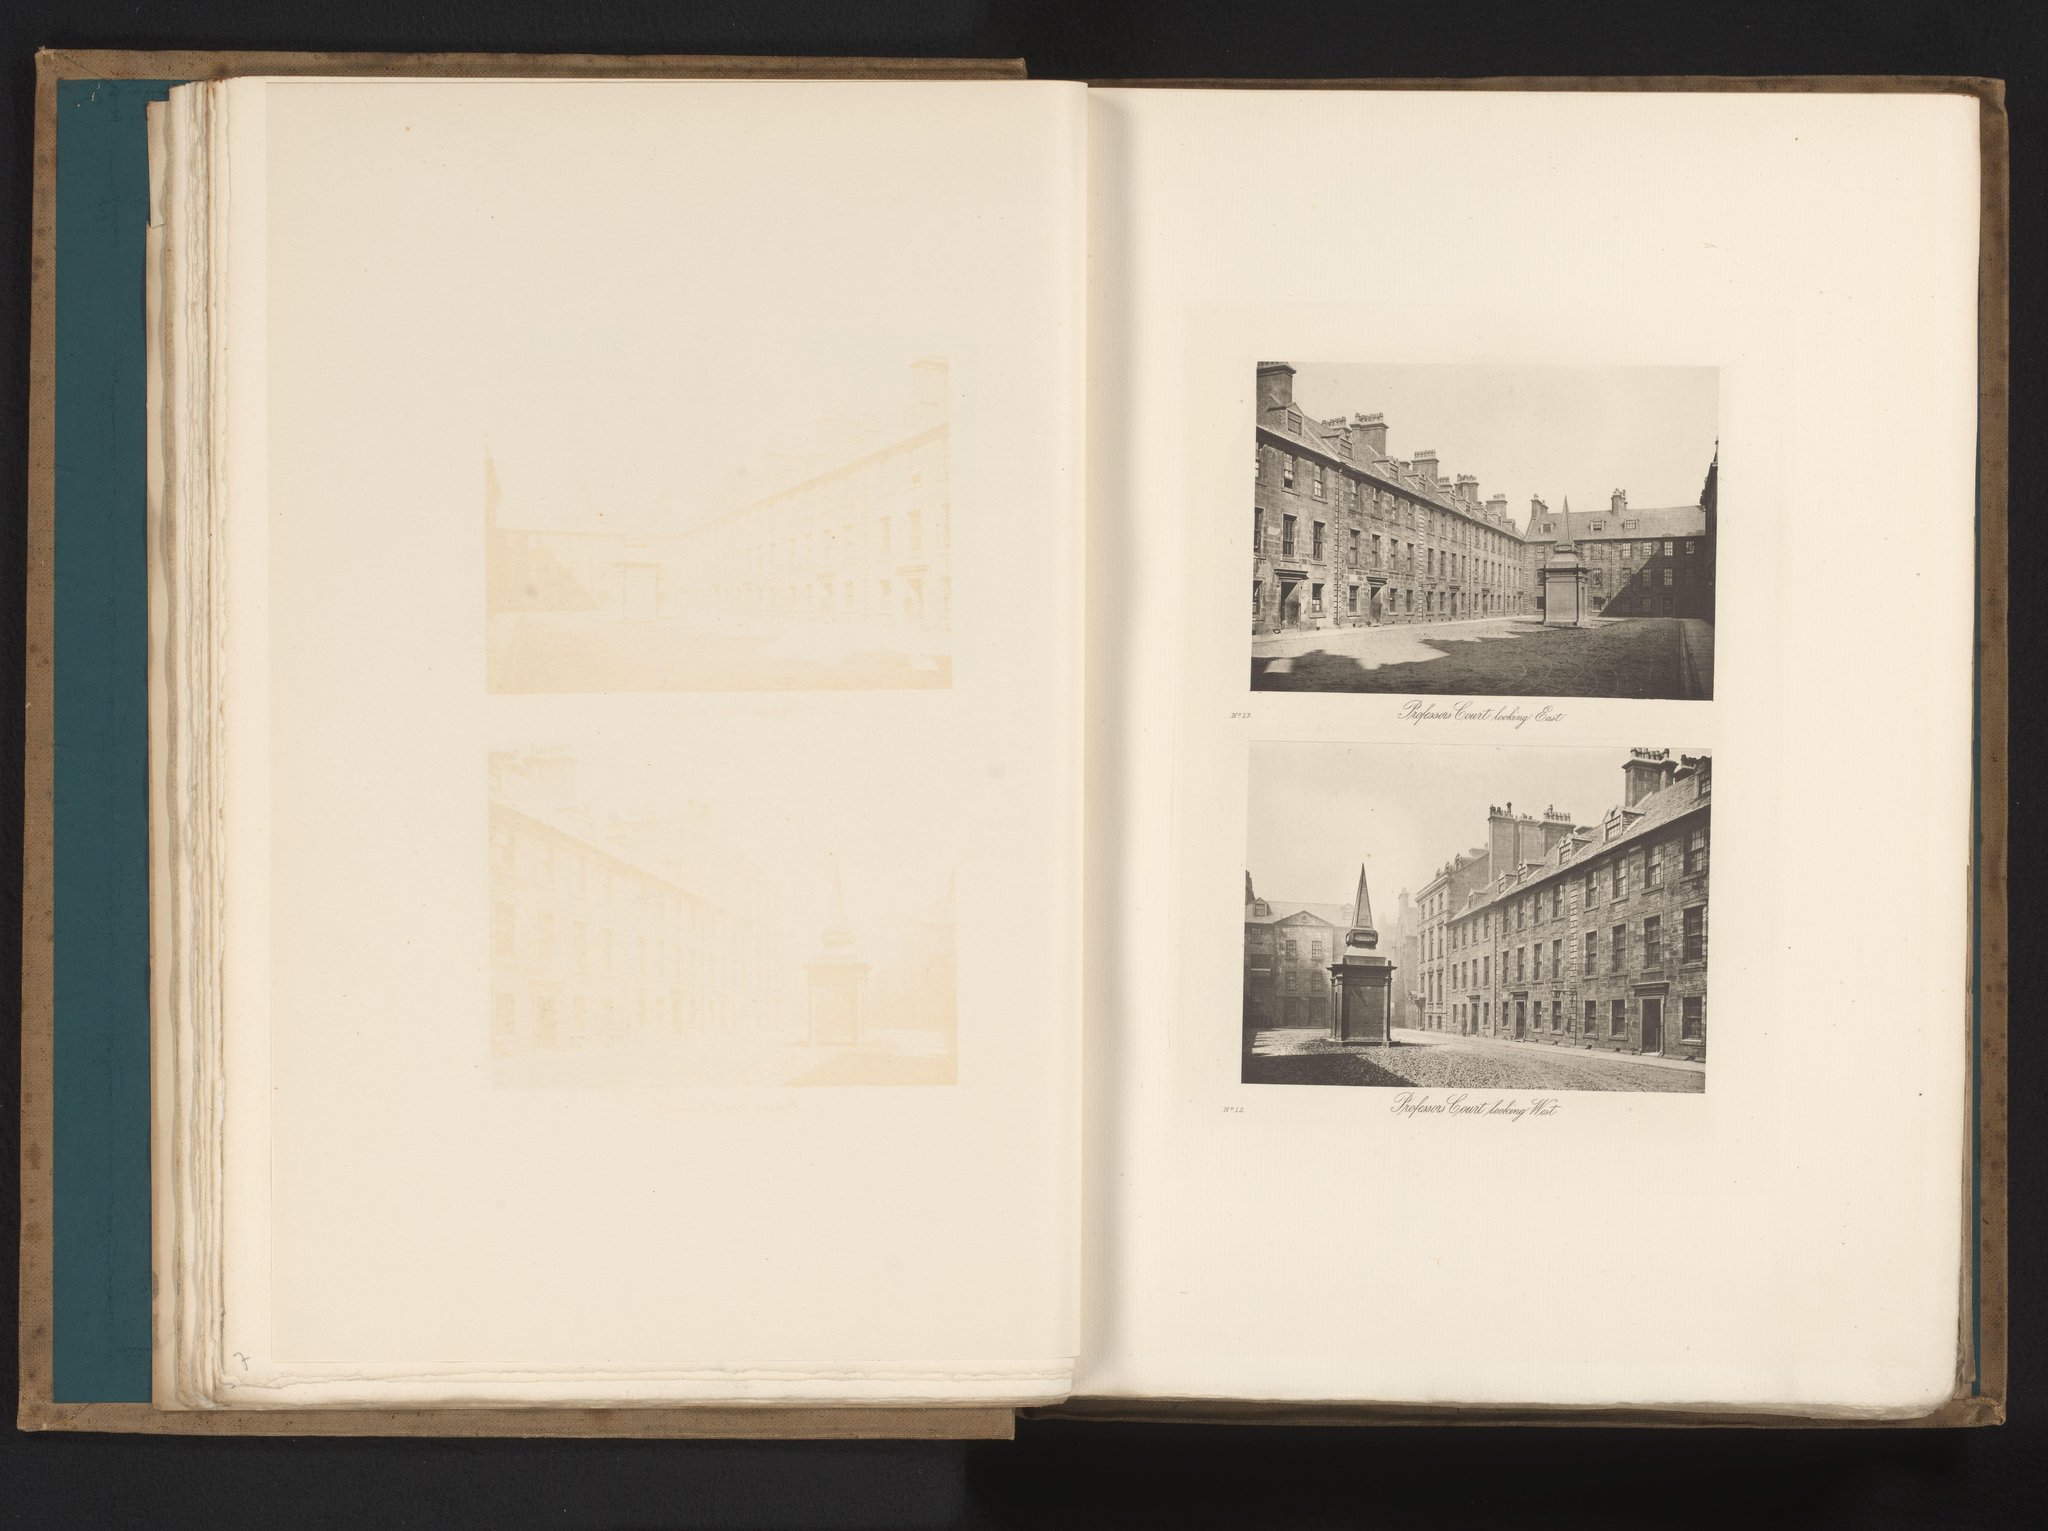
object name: photomechanical print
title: Professors Court looking East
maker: Anonymous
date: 1886-1891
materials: paper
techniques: photoaquatint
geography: glasgow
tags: university (+ building ~ education, tuition), courtyard, glasgow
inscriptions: inscription: ‘No.11/ No.10’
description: Prent op dertiende ongenummerde pagina na pagina iv.